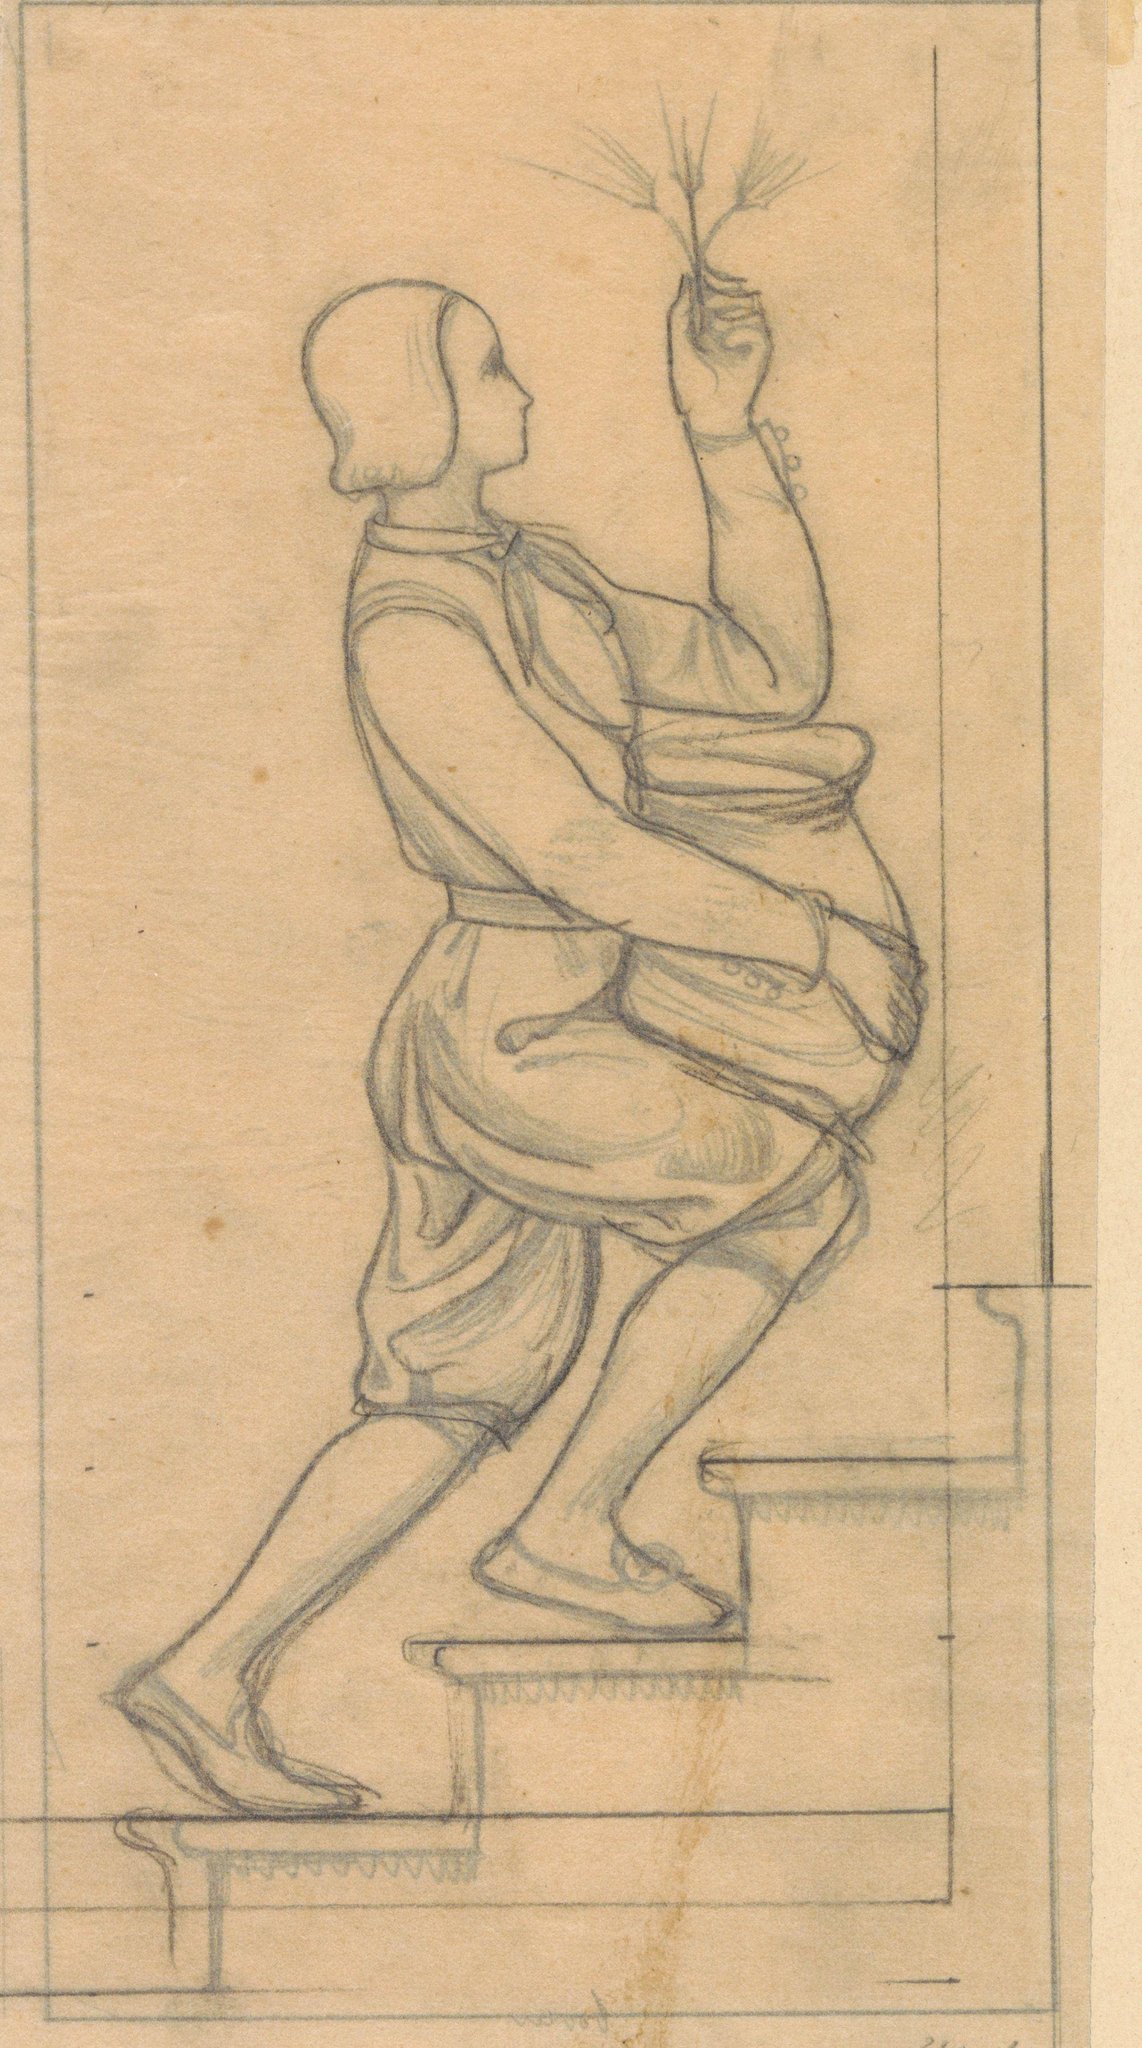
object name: design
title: Ontwerp voor wandschildering in de Beurs van Berlage: scène uit de legende van het vrouwtje van Stavoren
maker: antoon derkinderen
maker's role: draughtsman, painter, print maker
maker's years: 1859-1925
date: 1869-1925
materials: pencil, paper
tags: tales and fairy tales (vrouwtje van stavoren)